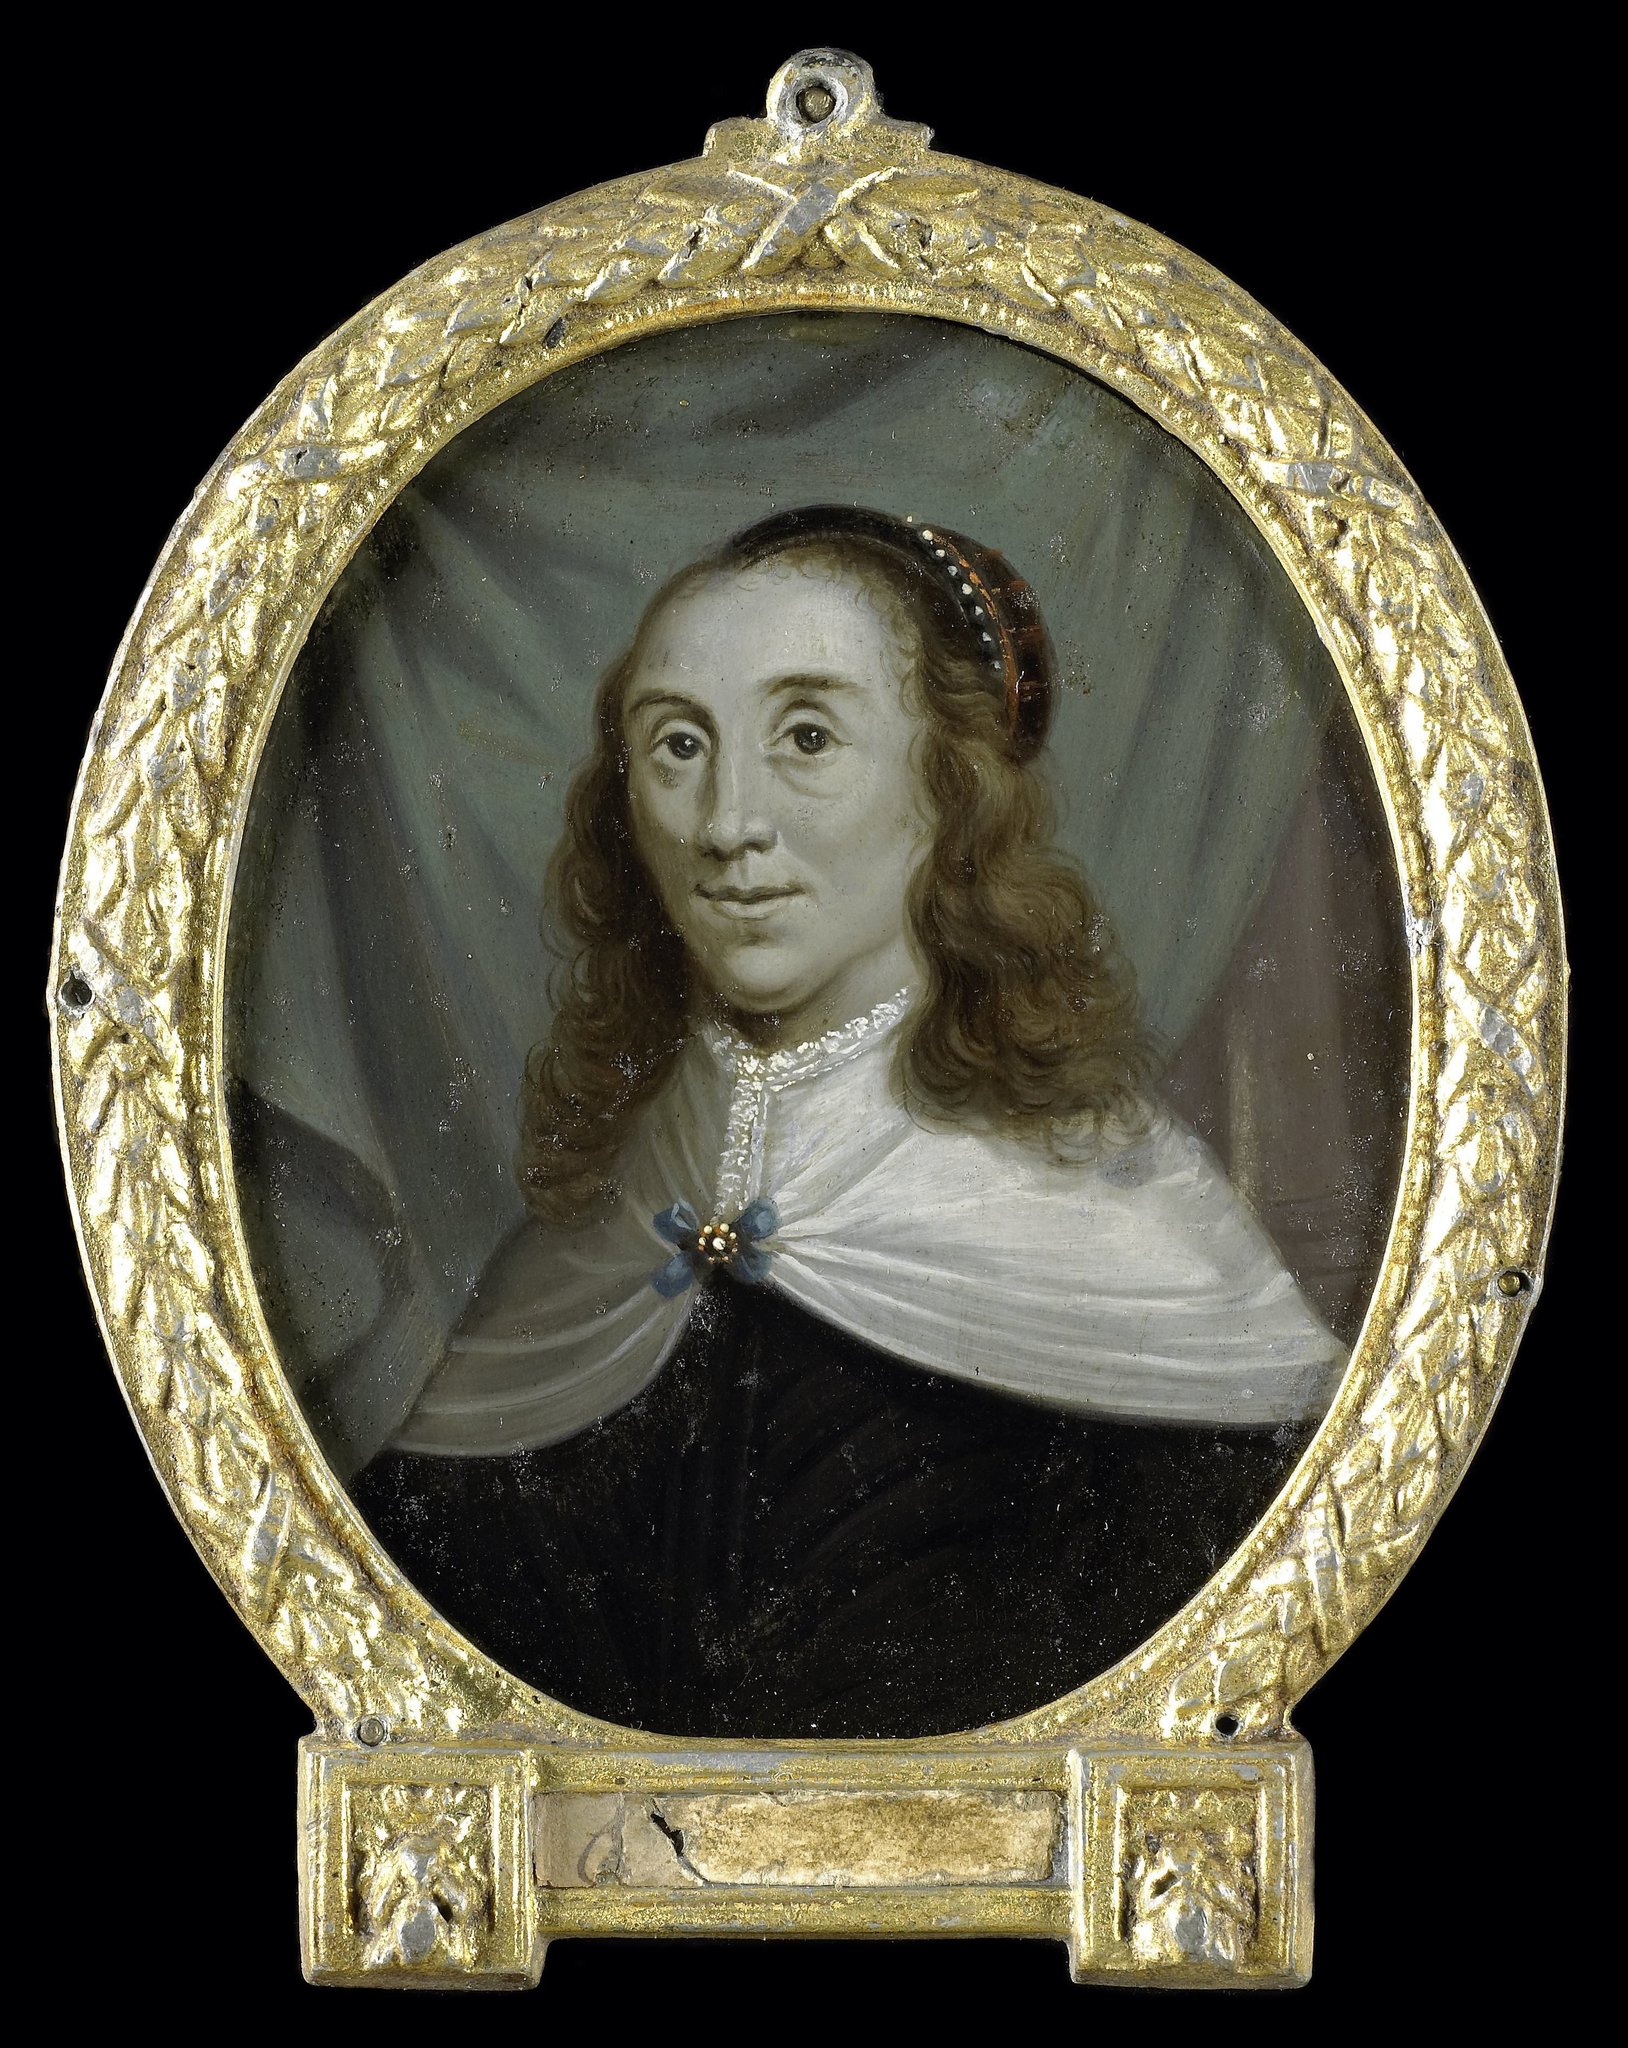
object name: painting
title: Portrait of Sibylle van Griethuysen, Poet in Groningen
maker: arnoud van halen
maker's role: draughtsman, painter, print maker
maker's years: 1673-1732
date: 1700-1732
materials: oil, metal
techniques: grisaille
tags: sibylle van griethuysen, portrait of a writer, writer, poet, author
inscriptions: inscription: ‘Sibilla van Griethuyse. Circa 1620’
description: Portret van Sibylle van Griethuysen (1621-99). Dichteres te Groningen. Buste in ovaal, iets naar links. Onderdeel van een verzameling portretten van Nederlandse dichters.